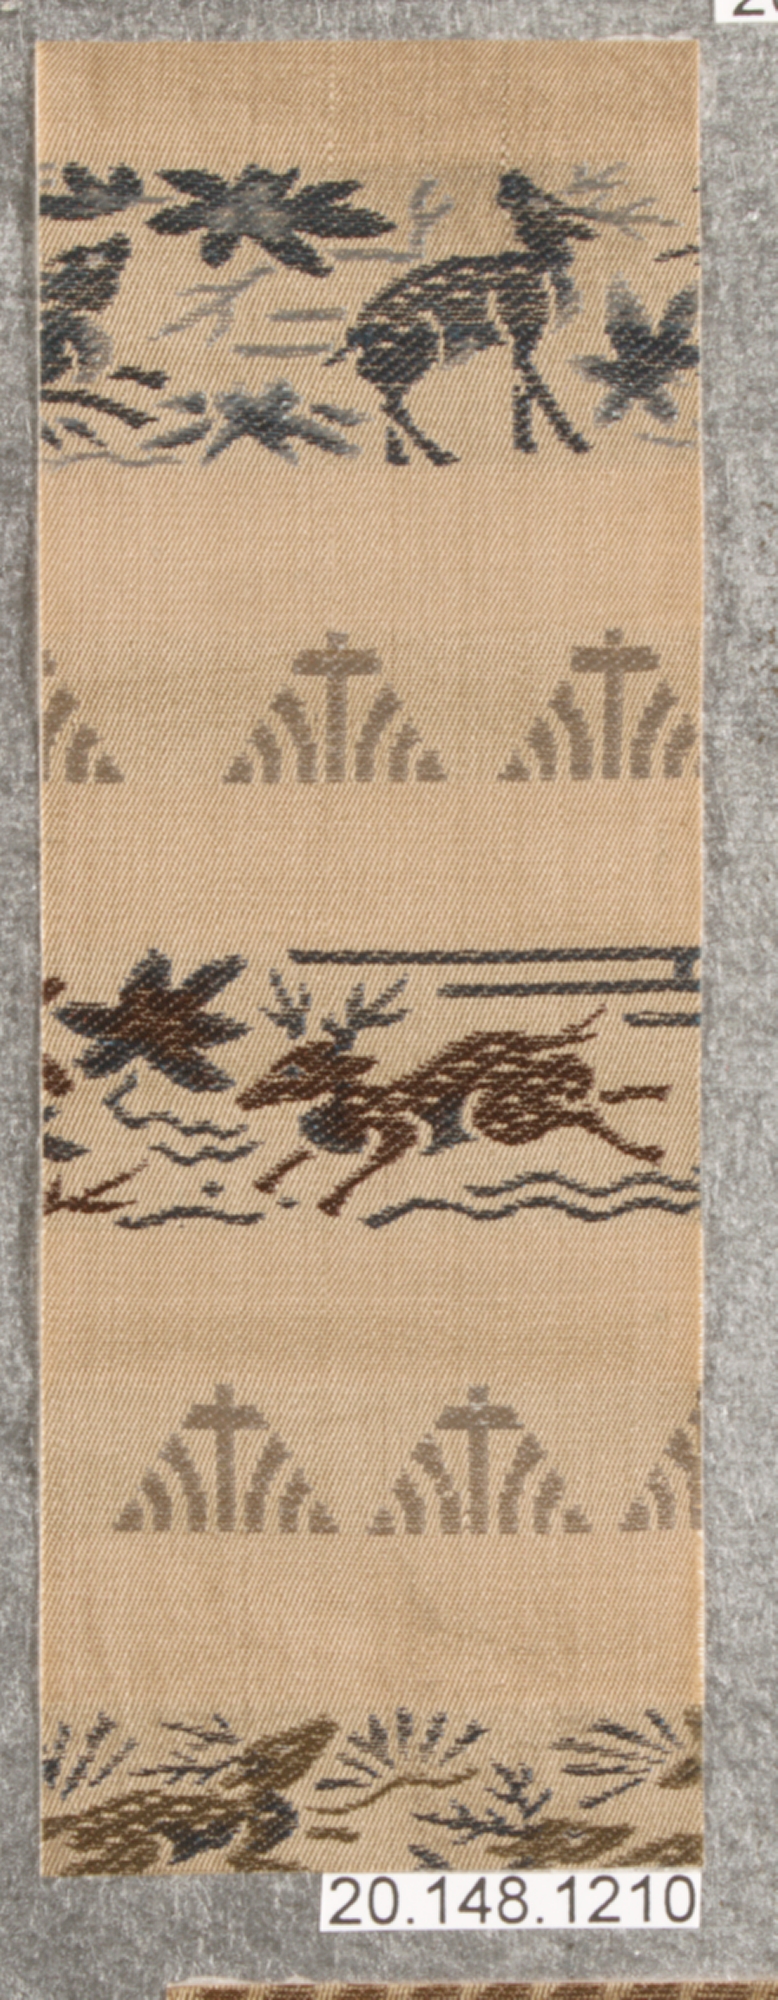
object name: piece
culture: japanese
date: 1801-1900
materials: silk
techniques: compound weave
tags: deer